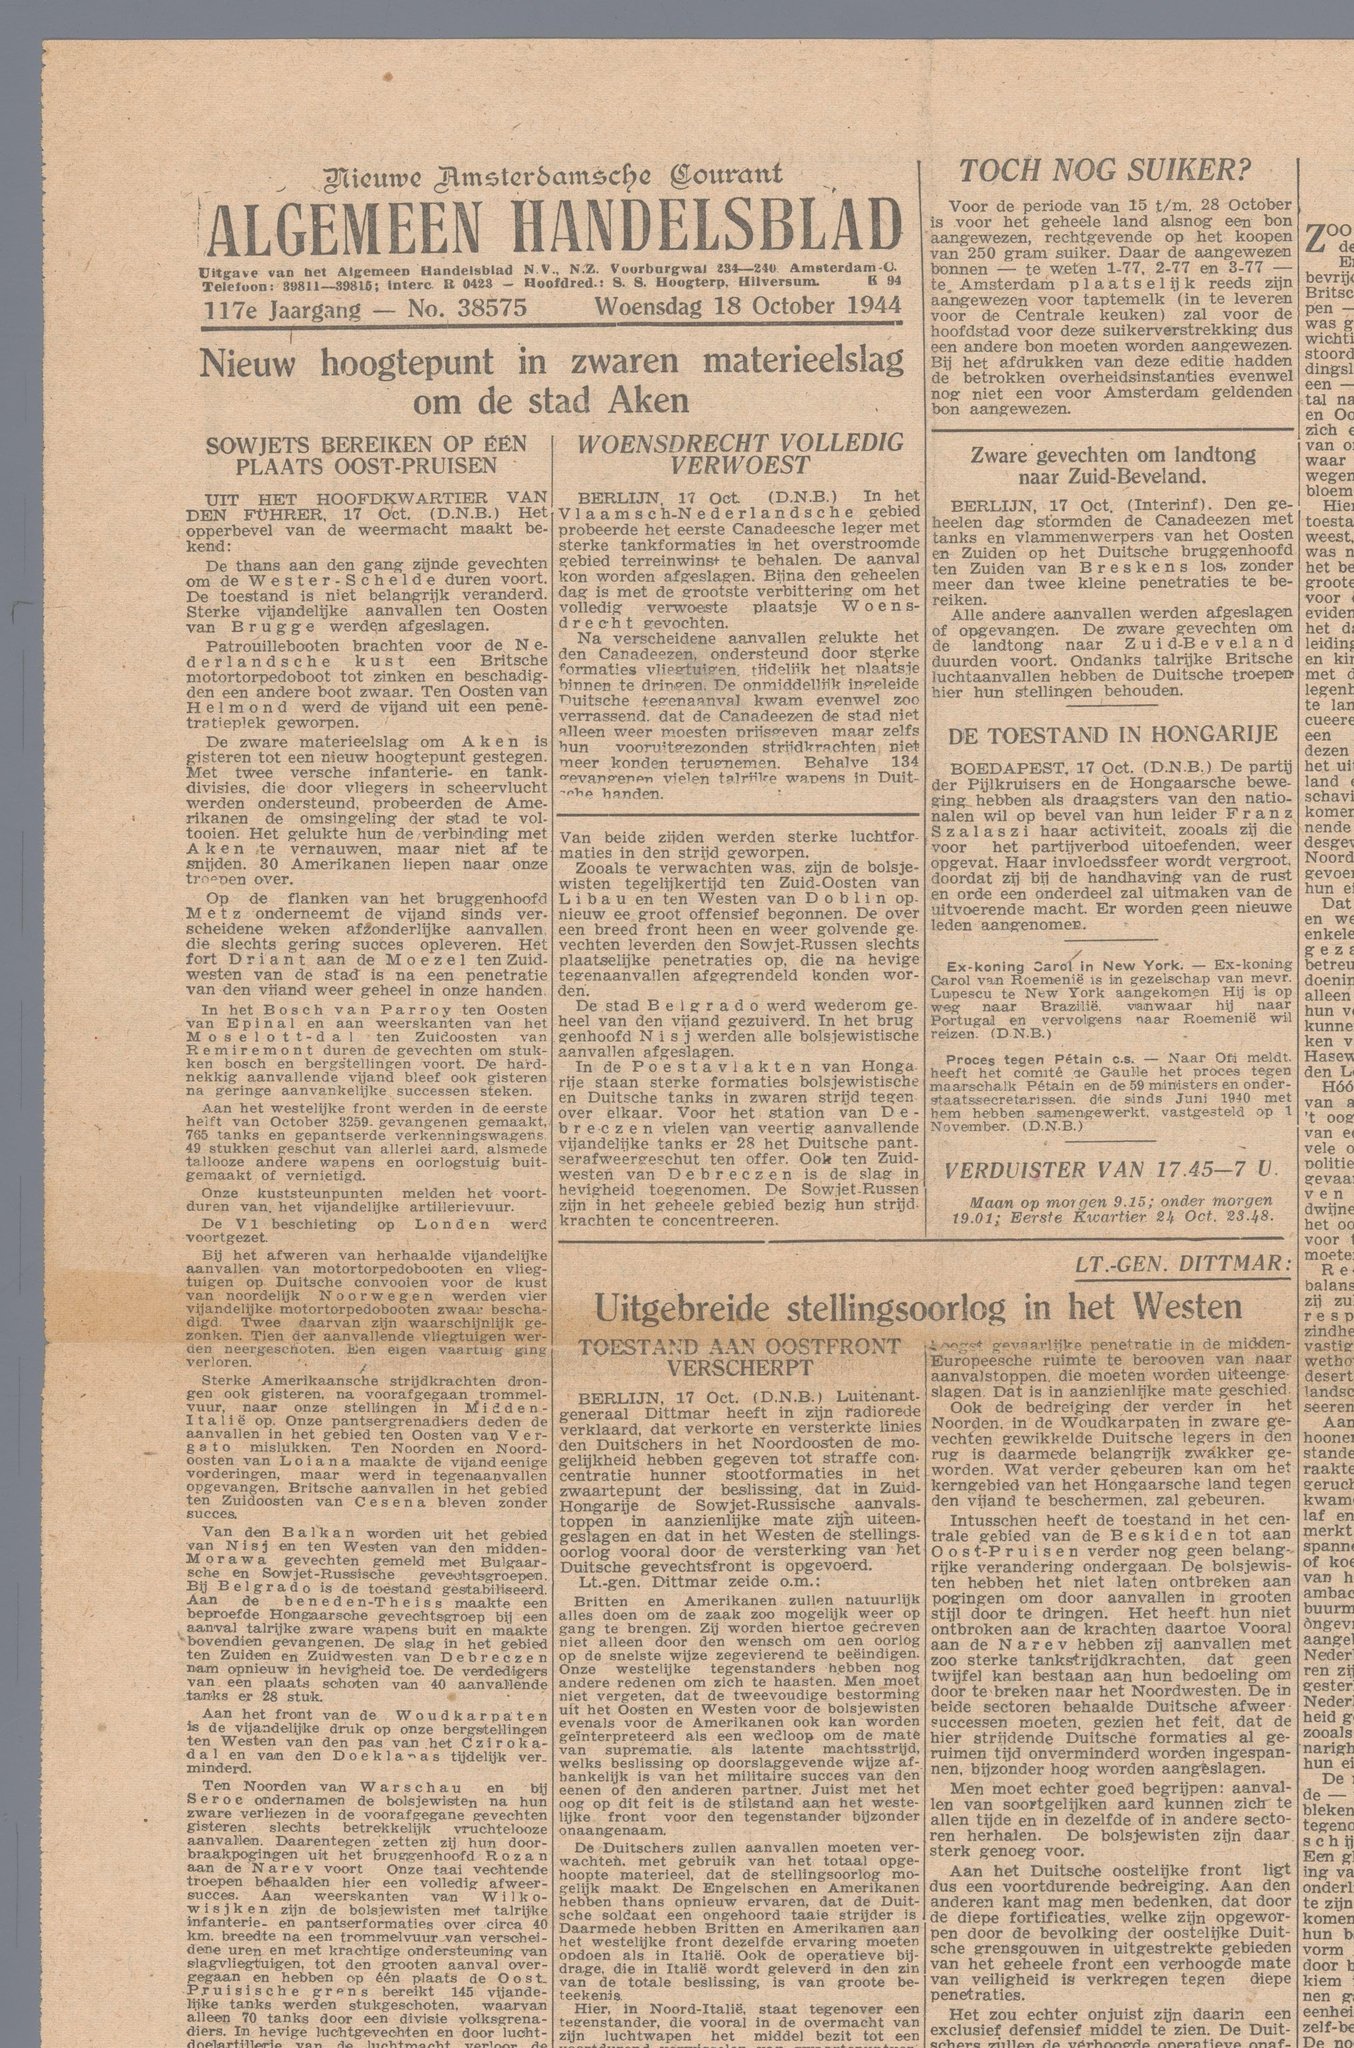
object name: newspaper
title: Algemeen Handelsblad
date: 1944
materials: paper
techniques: printing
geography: amsterdam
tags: tweede wereldoorlog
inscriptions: date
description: Krant, groot formaat, met bericht over de oorlog uit Duits gezinde hoek. Gedateerd: Woensdag, 18-10-1944.